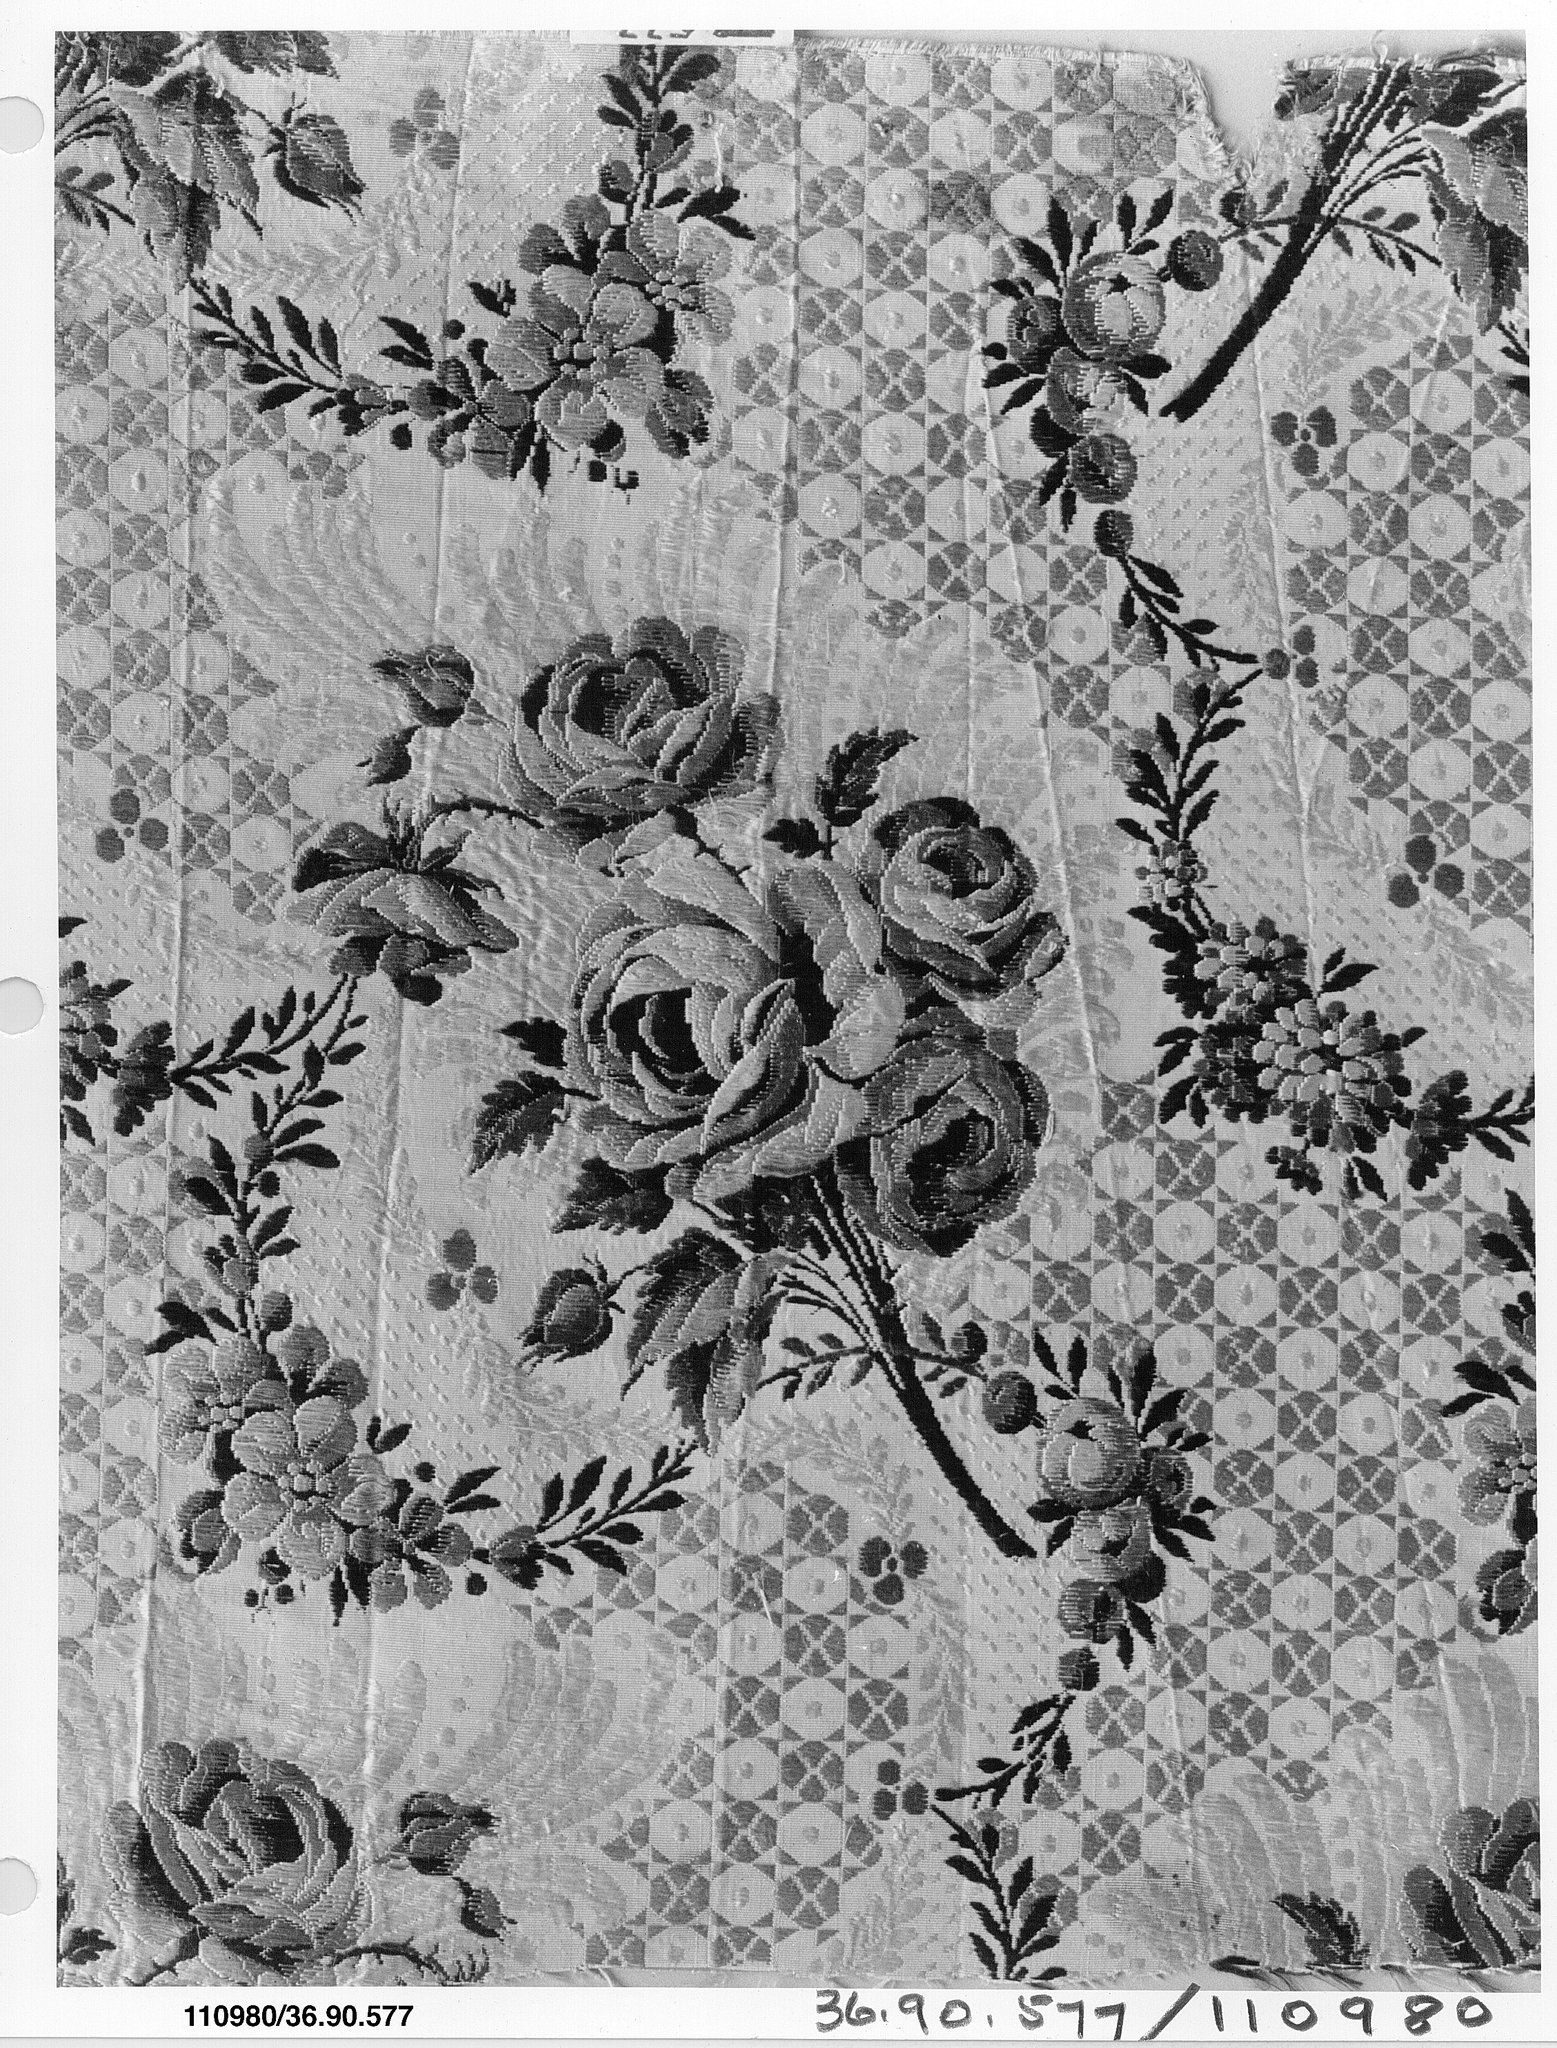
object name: piece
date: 1734-1766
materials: silk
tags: roses